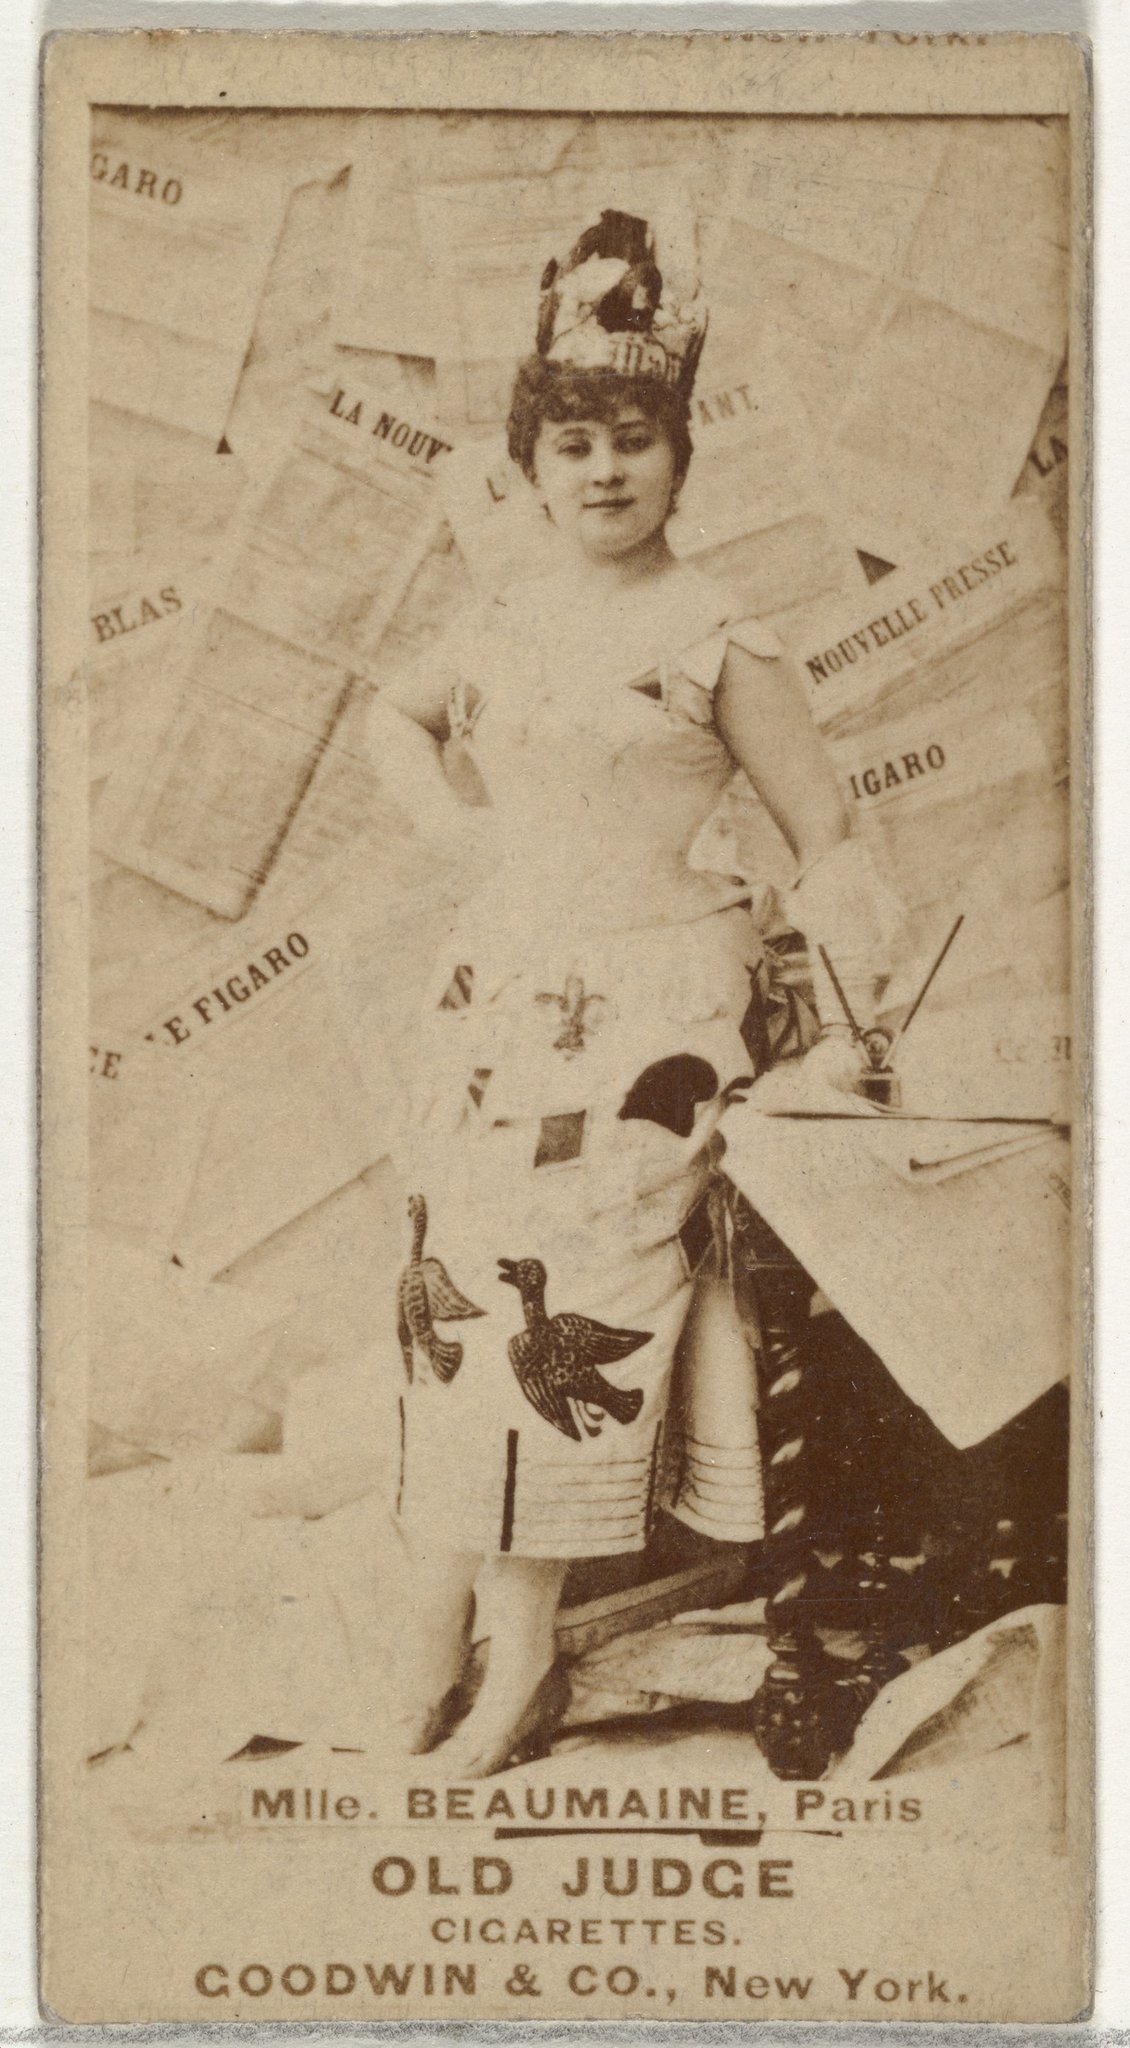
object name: photograph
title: Mlle. Beaumaine, Paris, from the Actors and Actresses series (N171) for Old Judge Cigarettes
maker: goodwin & company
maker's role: publisher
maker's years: 1850-1950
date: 1886-1890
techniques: albumen silver print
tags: portraits,women,actresses